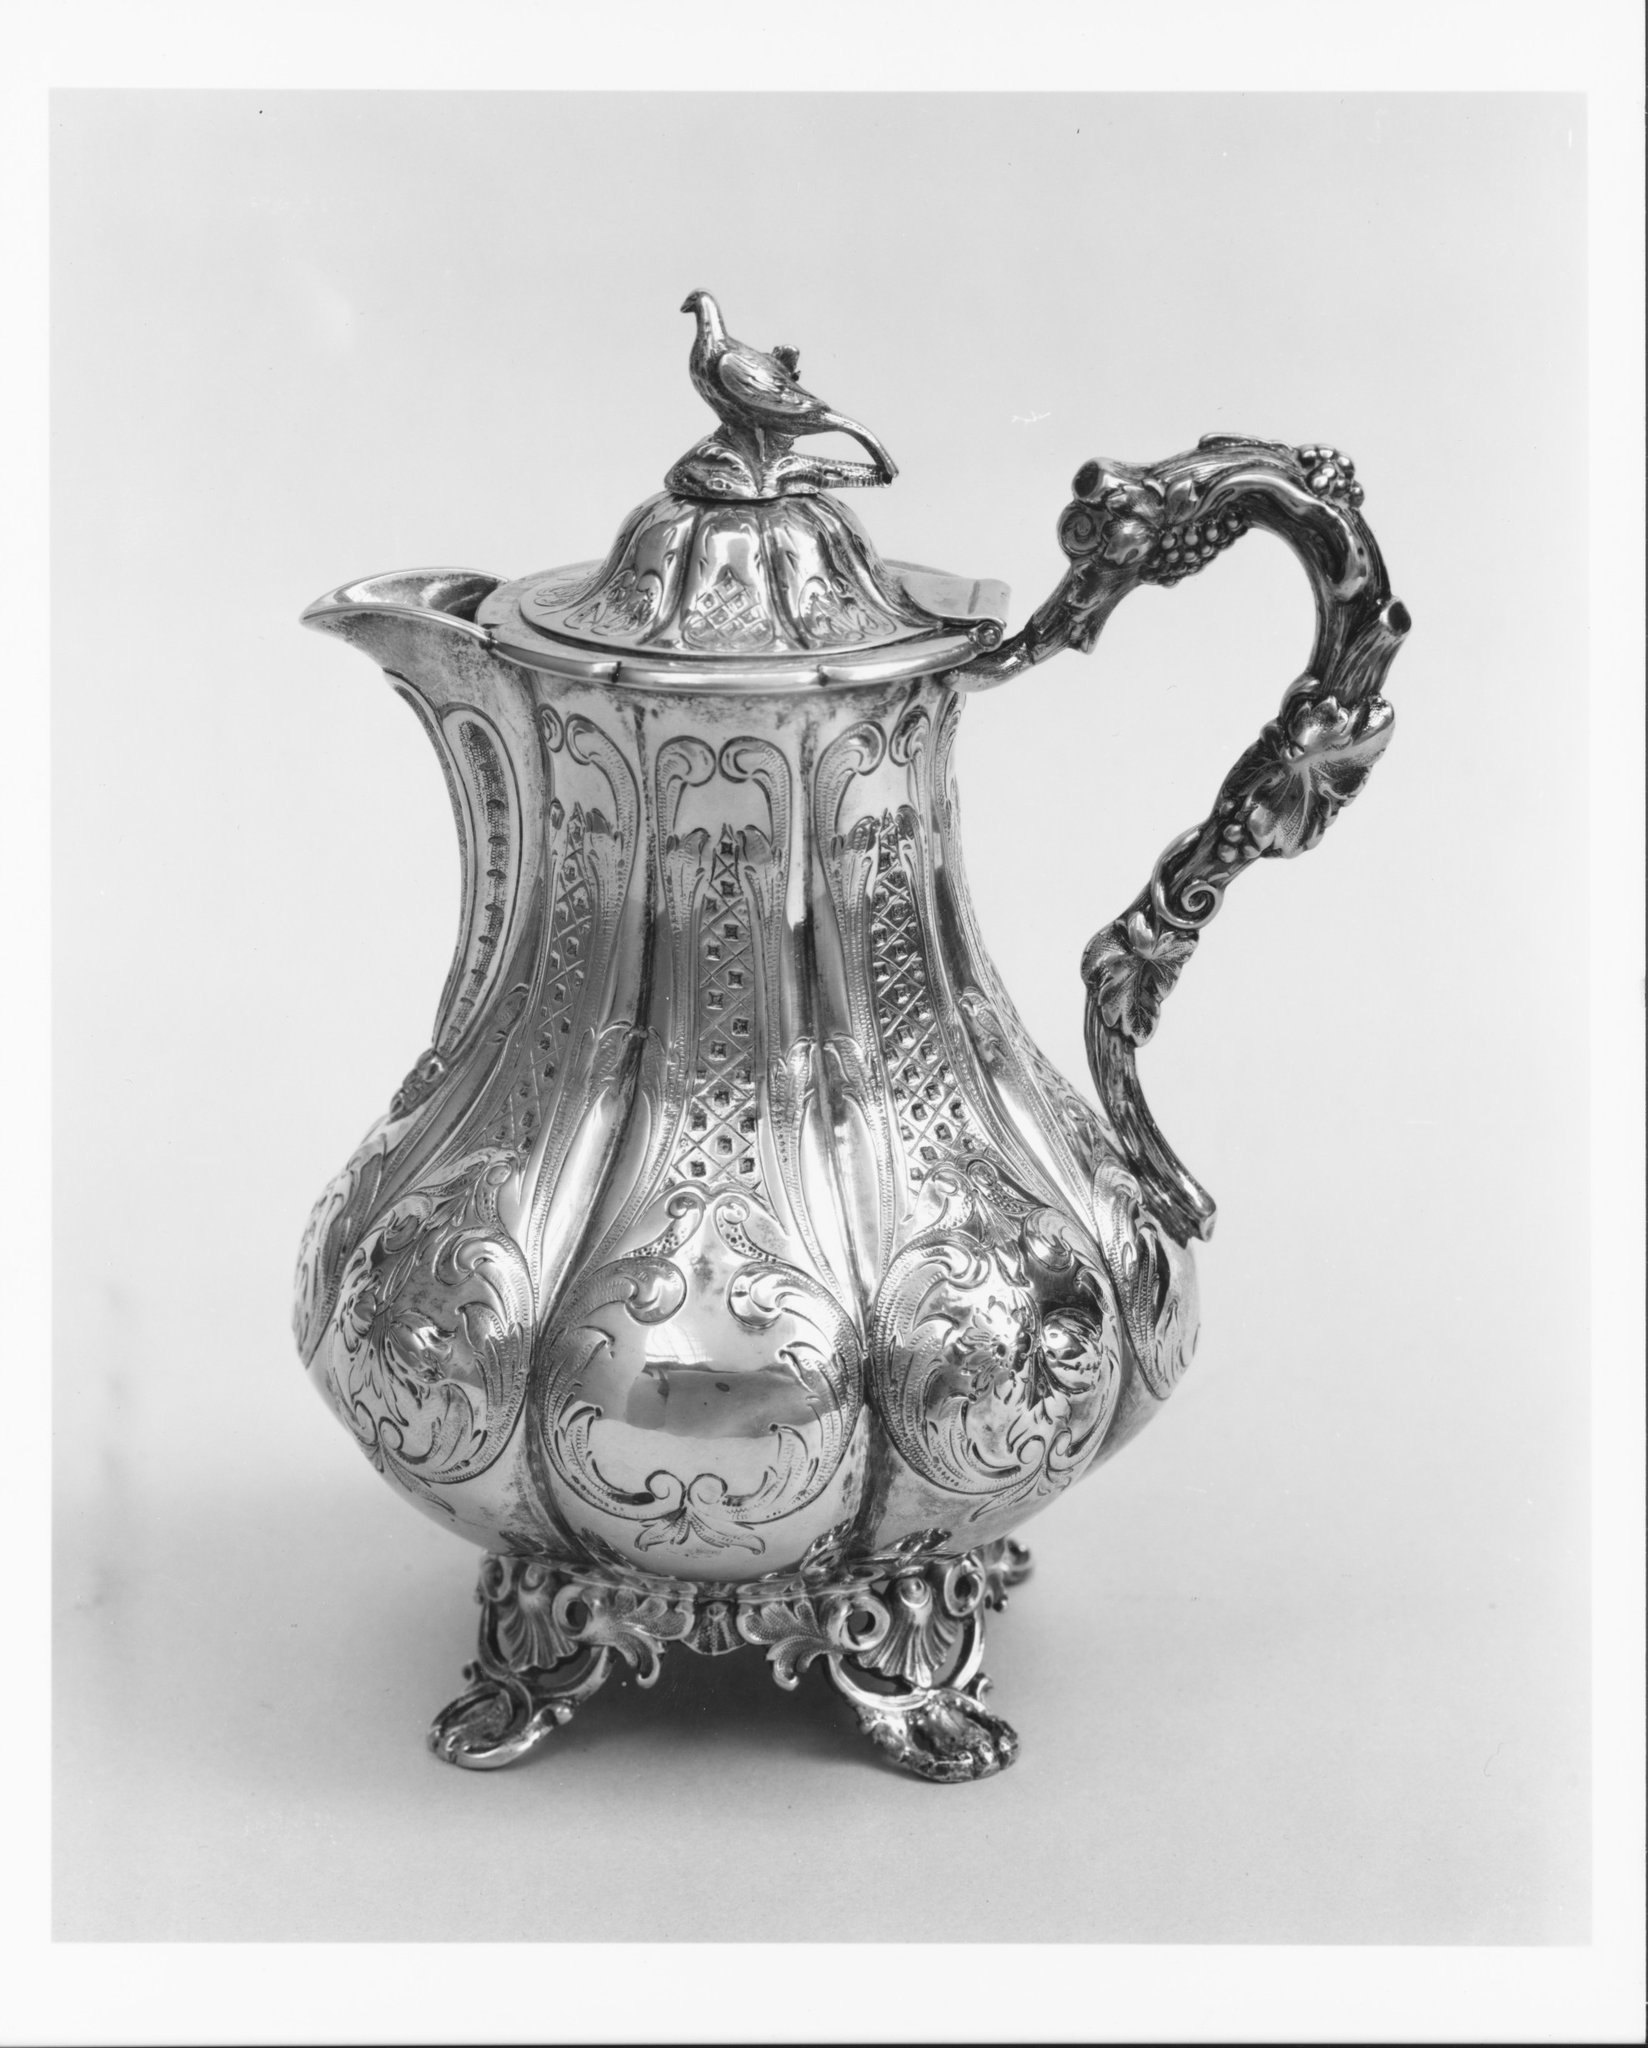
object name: cream pot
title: Creamer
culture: american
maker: ball, tompkins and black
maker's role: retailer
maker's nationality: american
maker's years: 1839-1851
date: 1848-1851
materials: silver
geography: united states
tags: birds